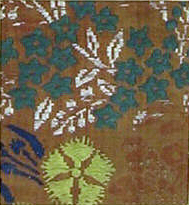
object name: piece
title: Textile with Autumn Grasses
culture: japanese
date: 1615-1868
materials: silk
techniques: brocade, weave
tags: flowers,leaves